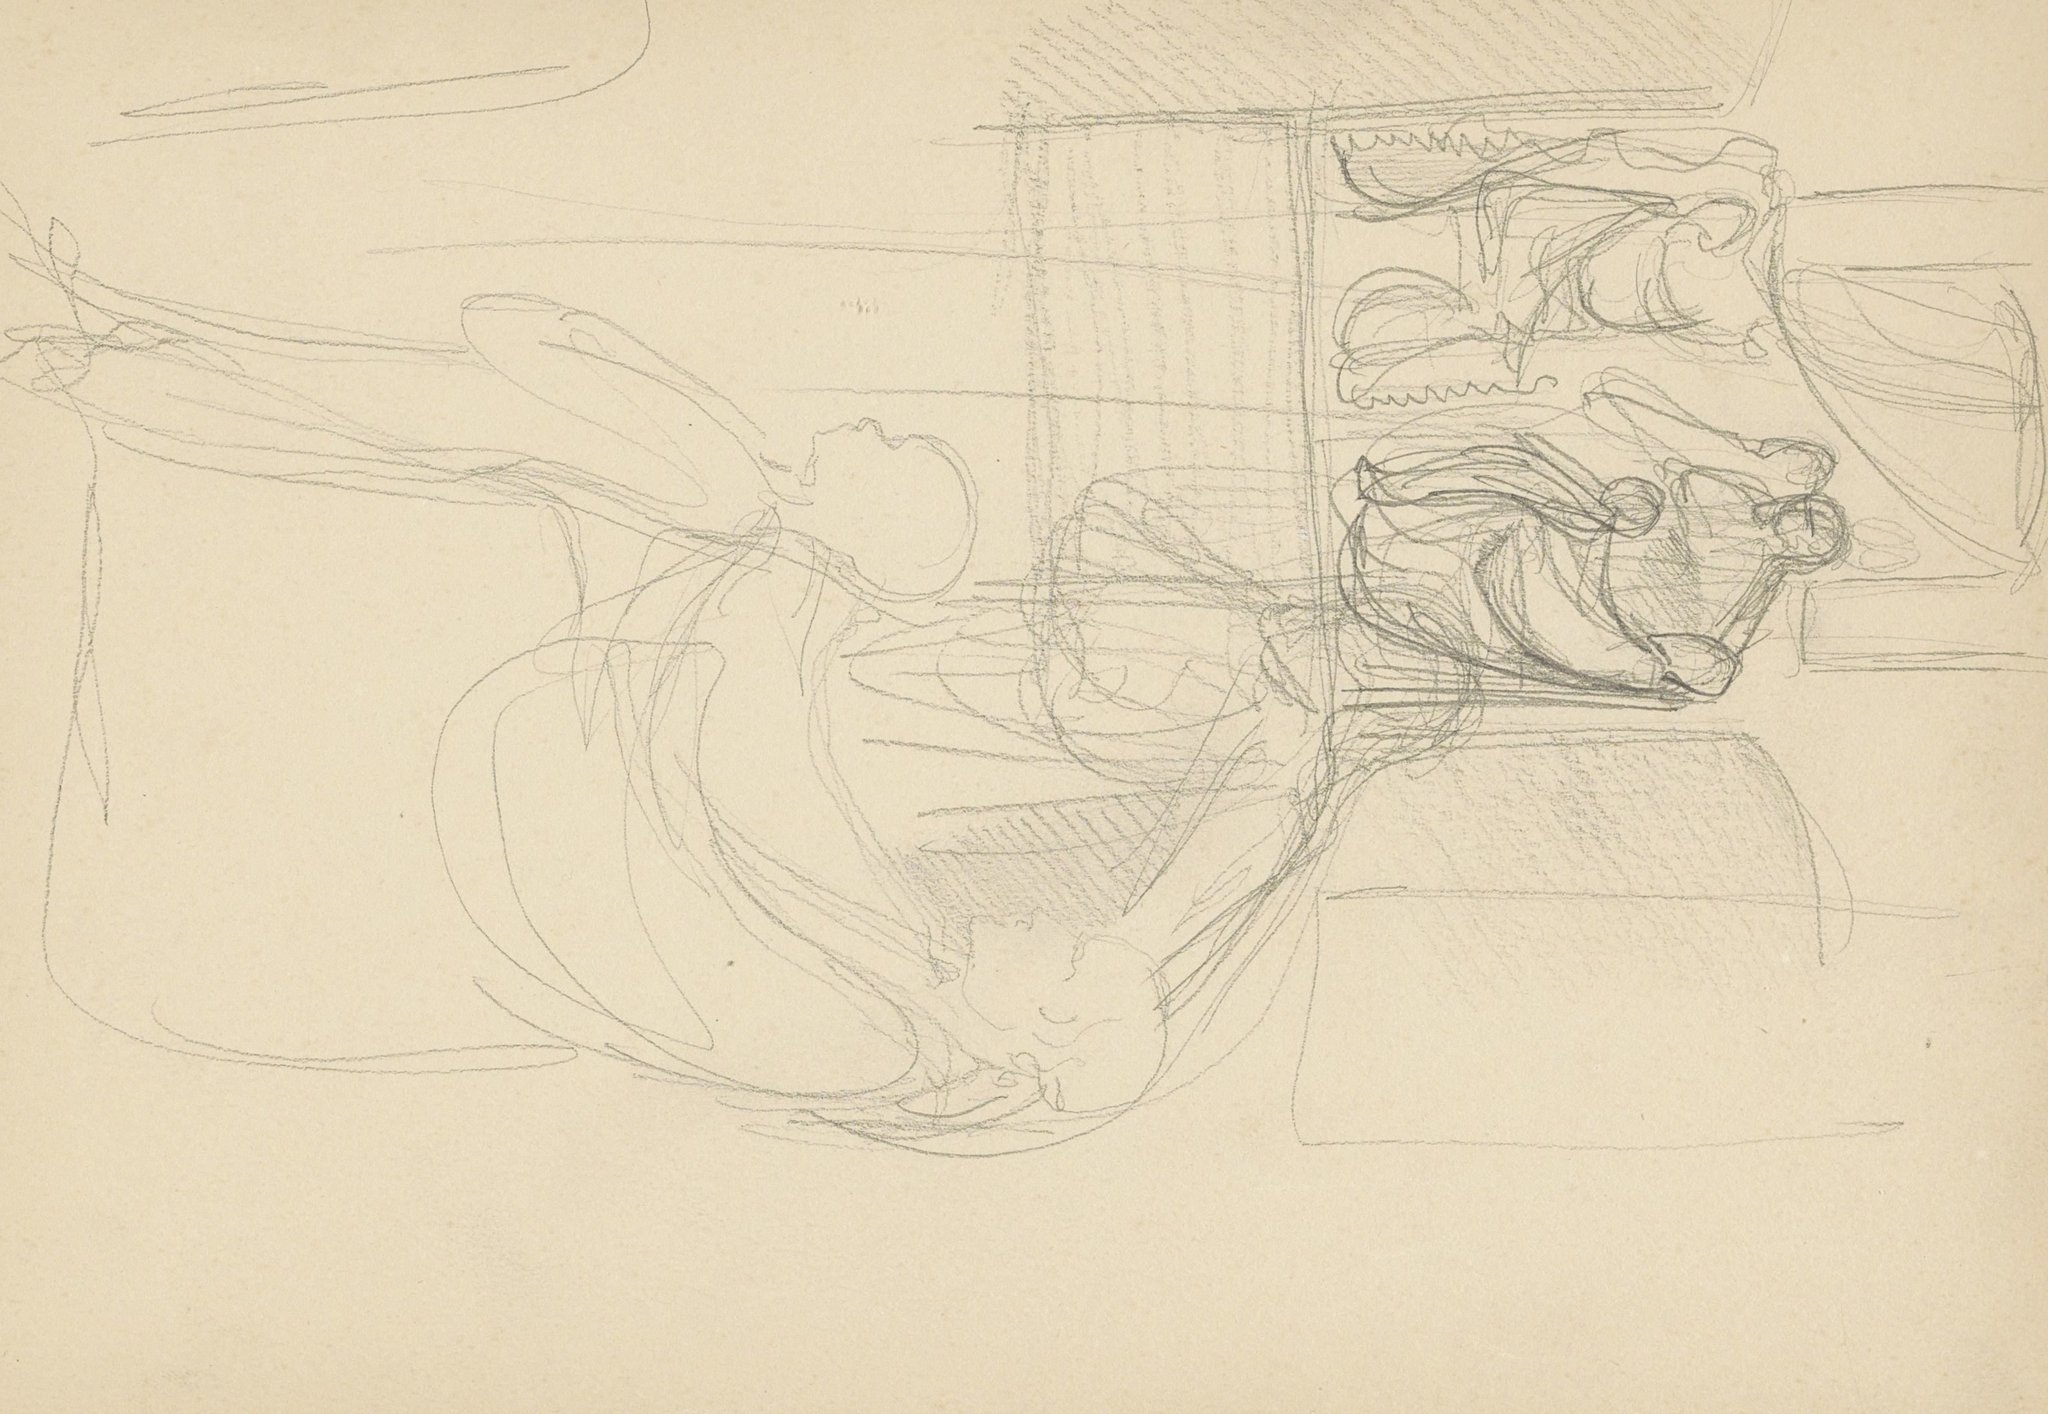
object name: sketchbook leaf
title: Familiegroep tegen een architecturale achtergrond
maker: antoon derkinderen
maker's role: draughtsman, painter, print maker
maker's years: 1859-1925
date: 1869-1925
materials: paper, pencil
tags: family group, especially parents with their child(ren), architecture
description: Blad 12 recto uit een schetsboek met 28 bladen.